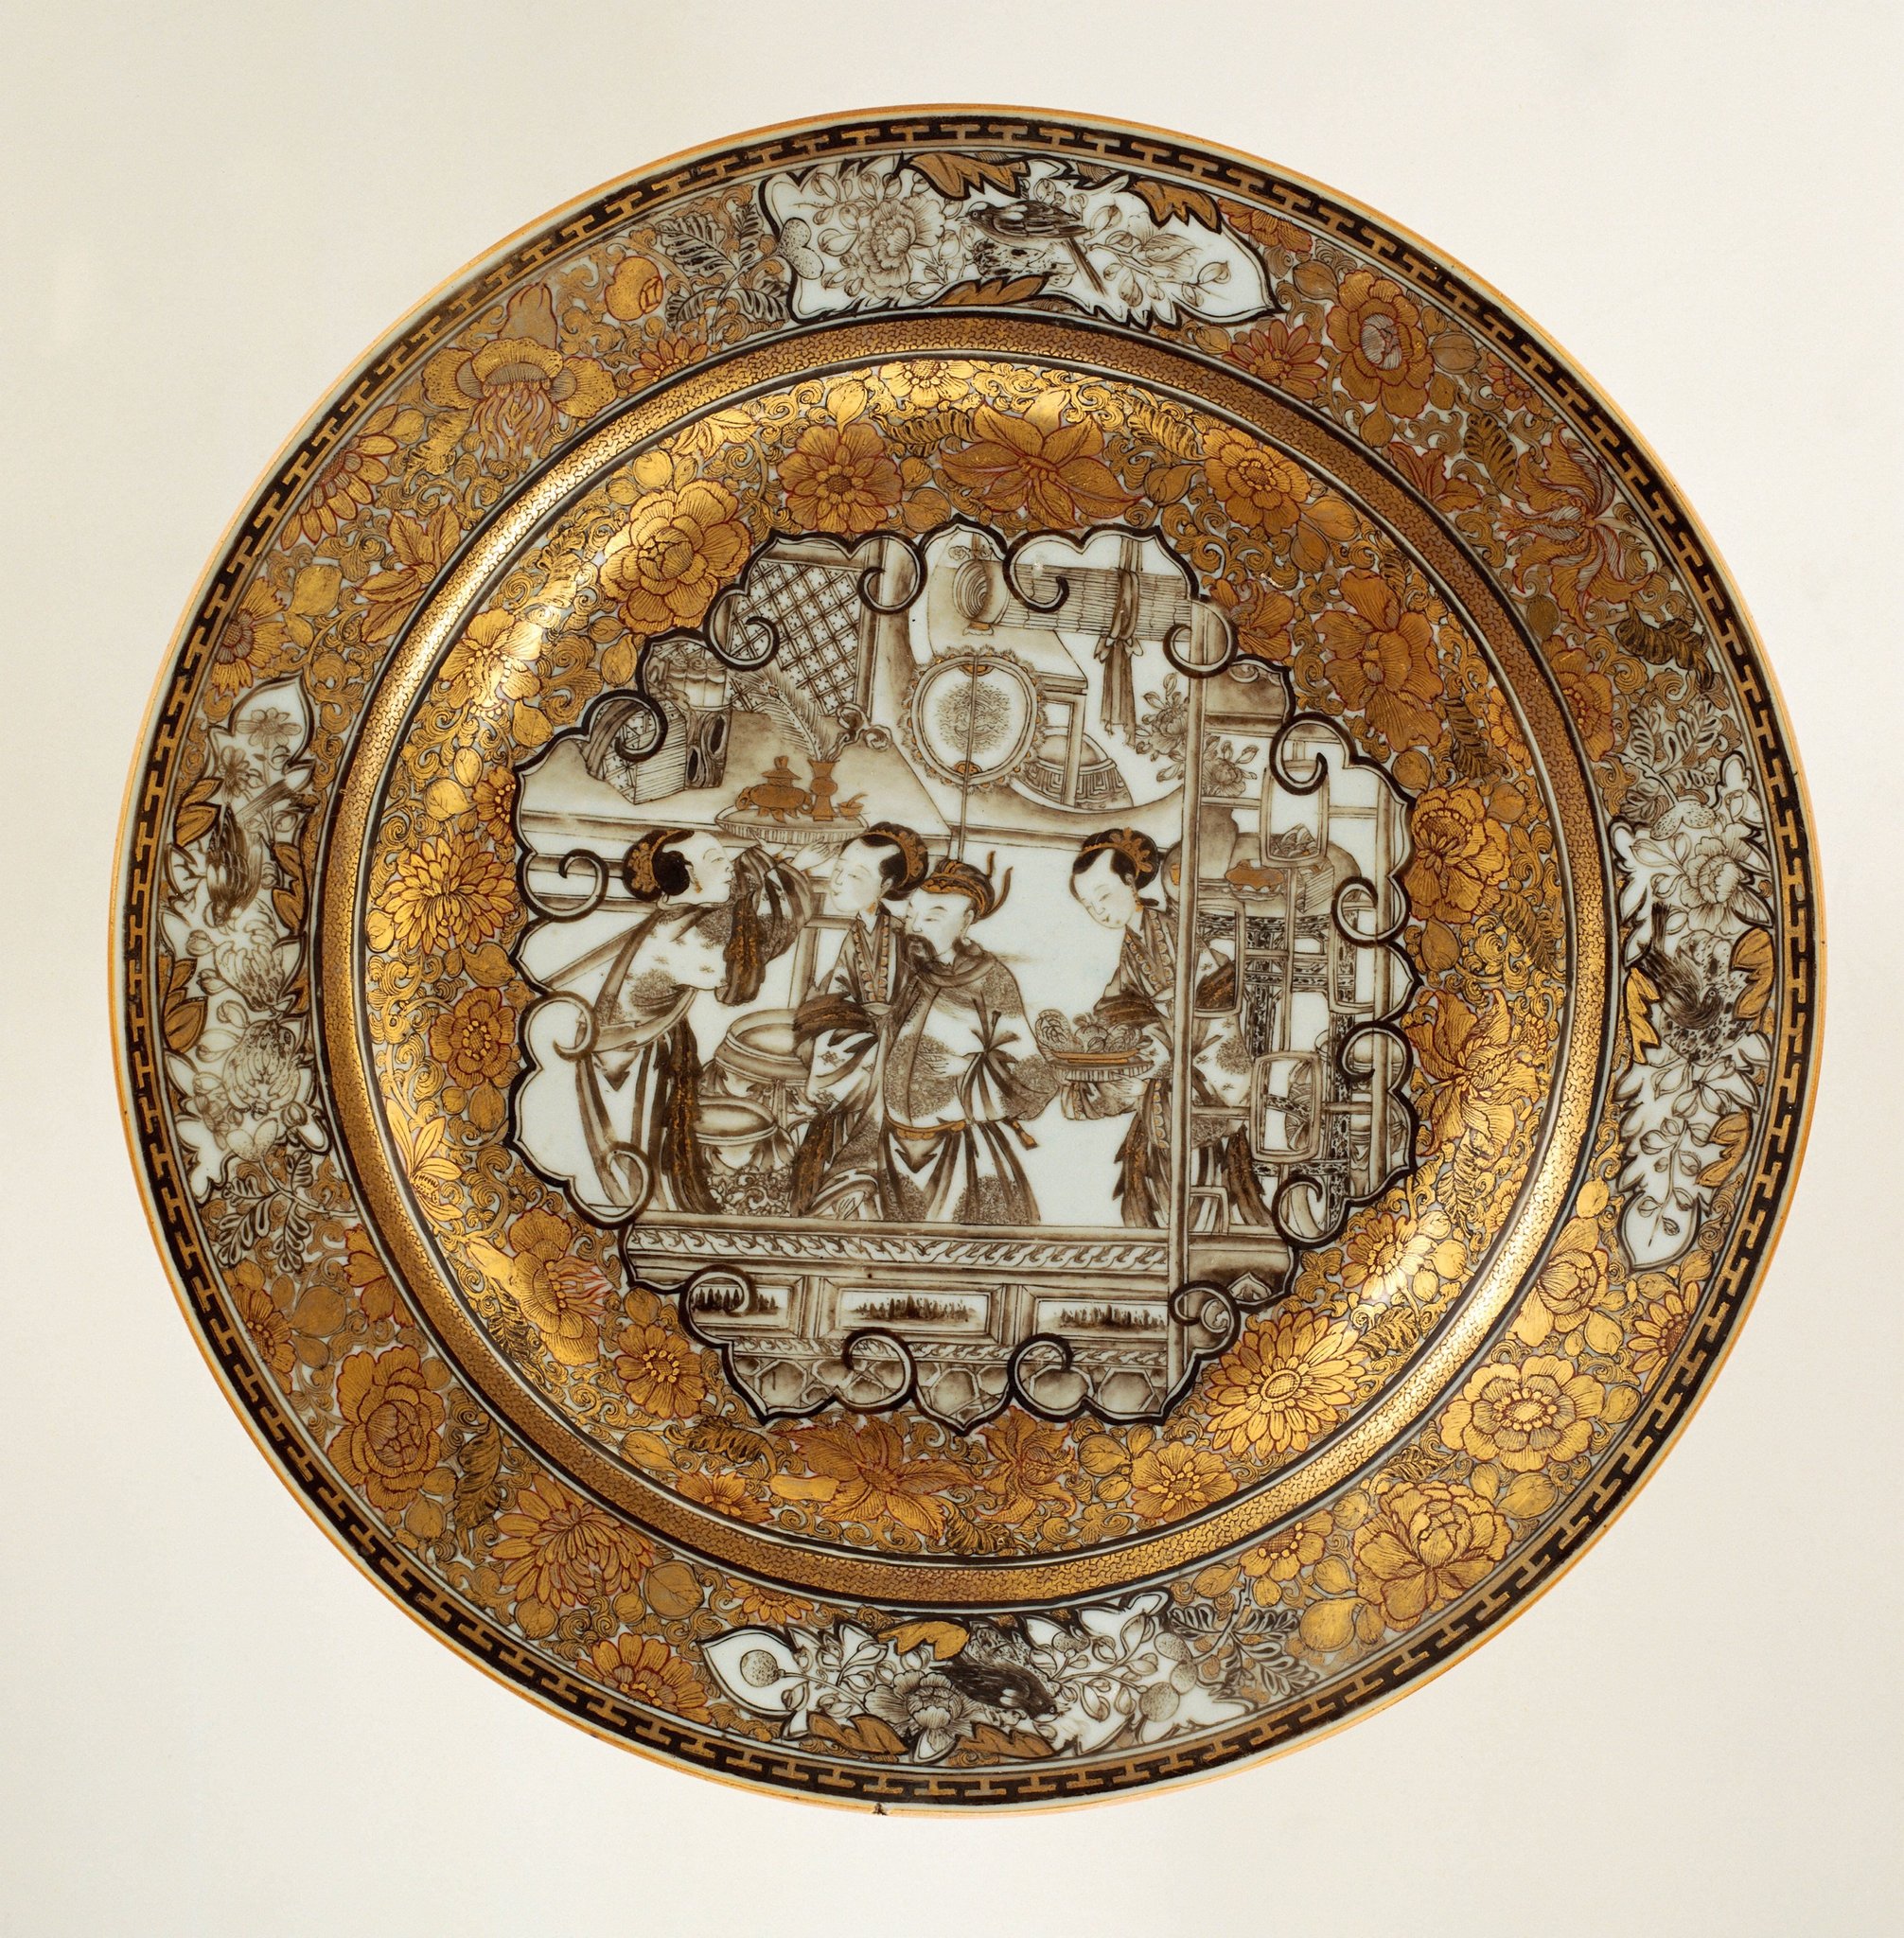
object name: platter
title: Dish depicting a dignitary and three servants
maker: Anonymous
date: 1725-1735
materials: glaze, gold, paint, porcelain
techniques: firing, gilding, turning, vitrification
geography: china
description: Bord in 'encre de chine', met op het plat een mandarijnen decor voorstellende een man en vrouw aan wie 2 meisjes een theeblad en een mand met vruchten brengen. Op de rand, tussen bloemen, vier medaillons met bloemen en een vogel.